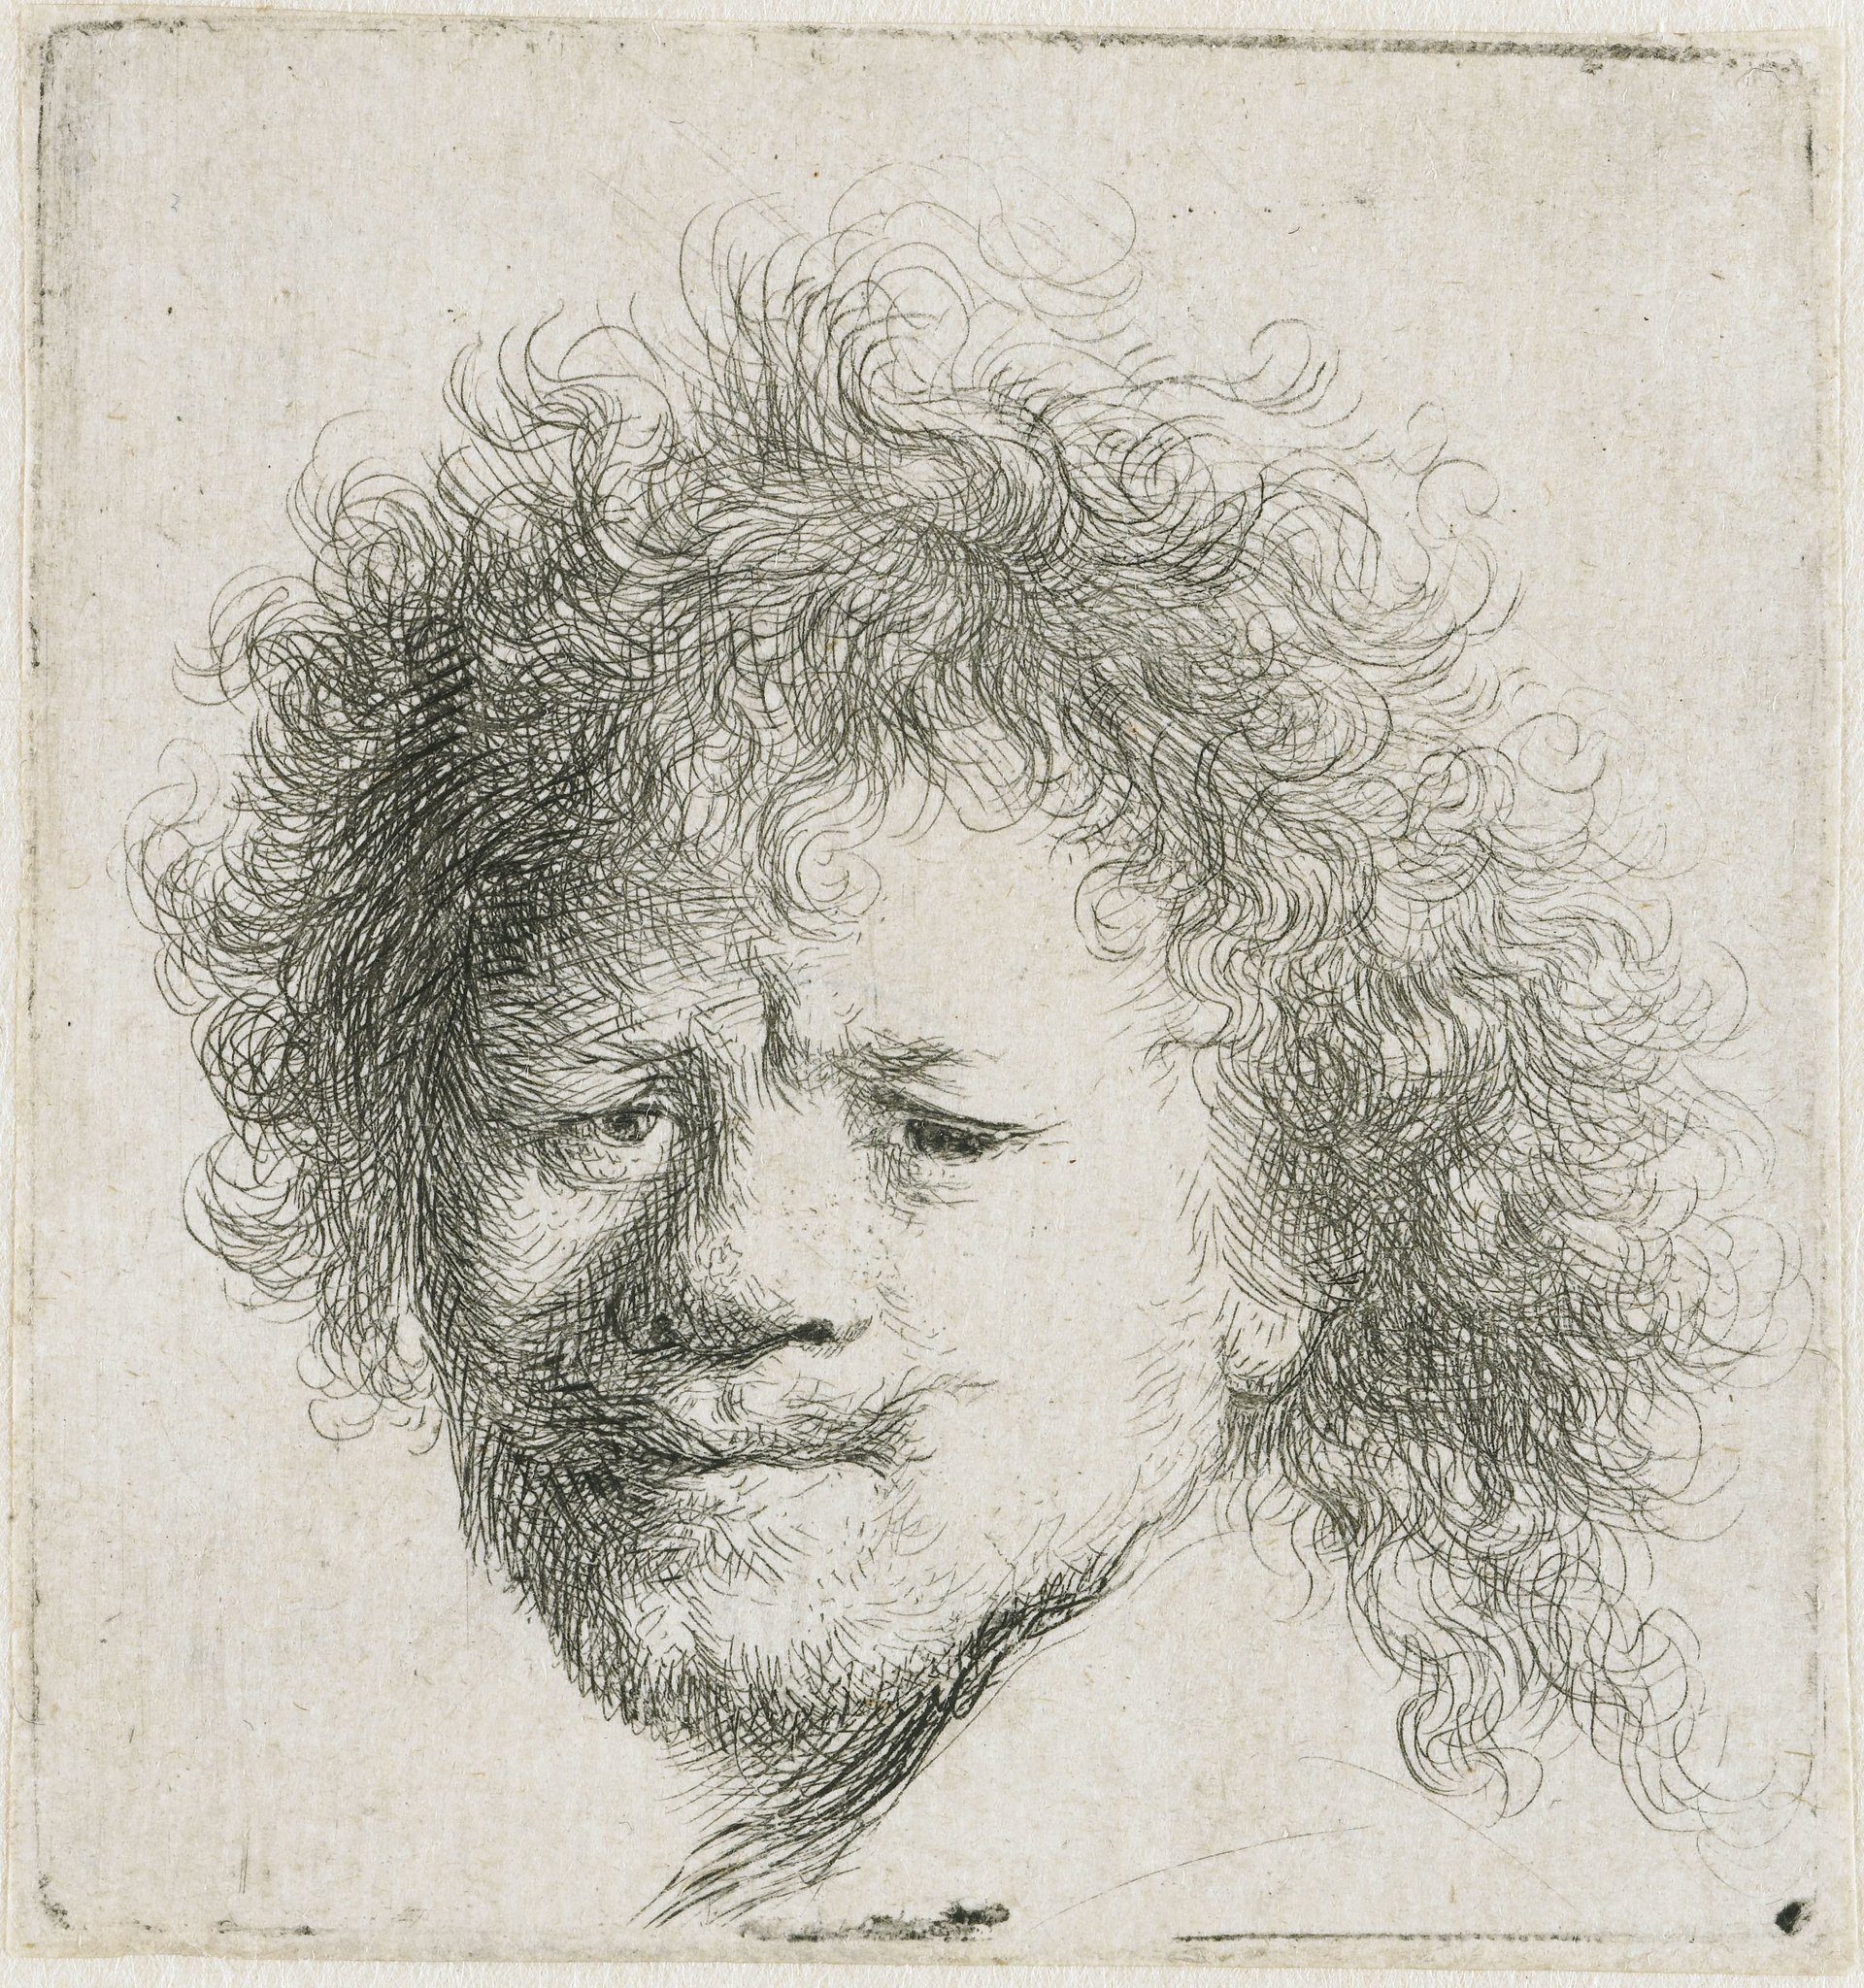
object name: print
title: Self-portrait with long bushy hair: head only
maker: rembrandt van rijn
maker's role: draughtsman, painter, print maker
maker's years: 1606-1669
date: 1631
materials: paper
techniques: etching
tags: leiden, amsterdam, painter, print maker, draughtsman, rembrandt van rijn, historical persons, portrait, self-portrait of painter, portrait, self-portrait of graphic artist, portrait, self-portrait of draughtsman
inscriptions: collector's mark: Lugt 2760, collector's mark: Lugt 2228 a